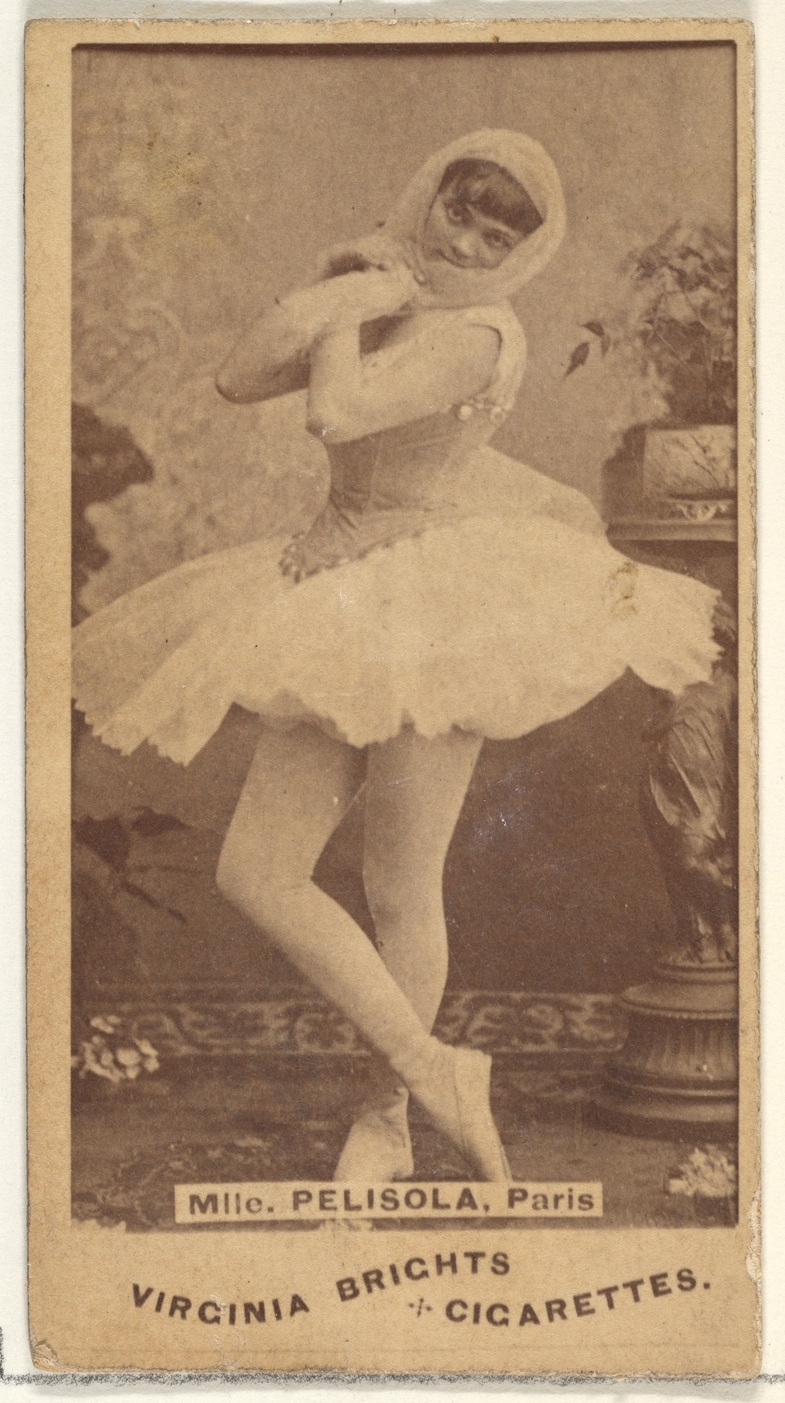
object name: photograph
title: Mlle. Pelisola, Paris, from the Actors and Actresses series (N45, Type 1) for Virginia Brights Cigarettes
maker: allen & ginter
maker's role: publisher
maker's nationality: american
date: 1888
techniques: albumen silver print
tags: portraits,women,actresses